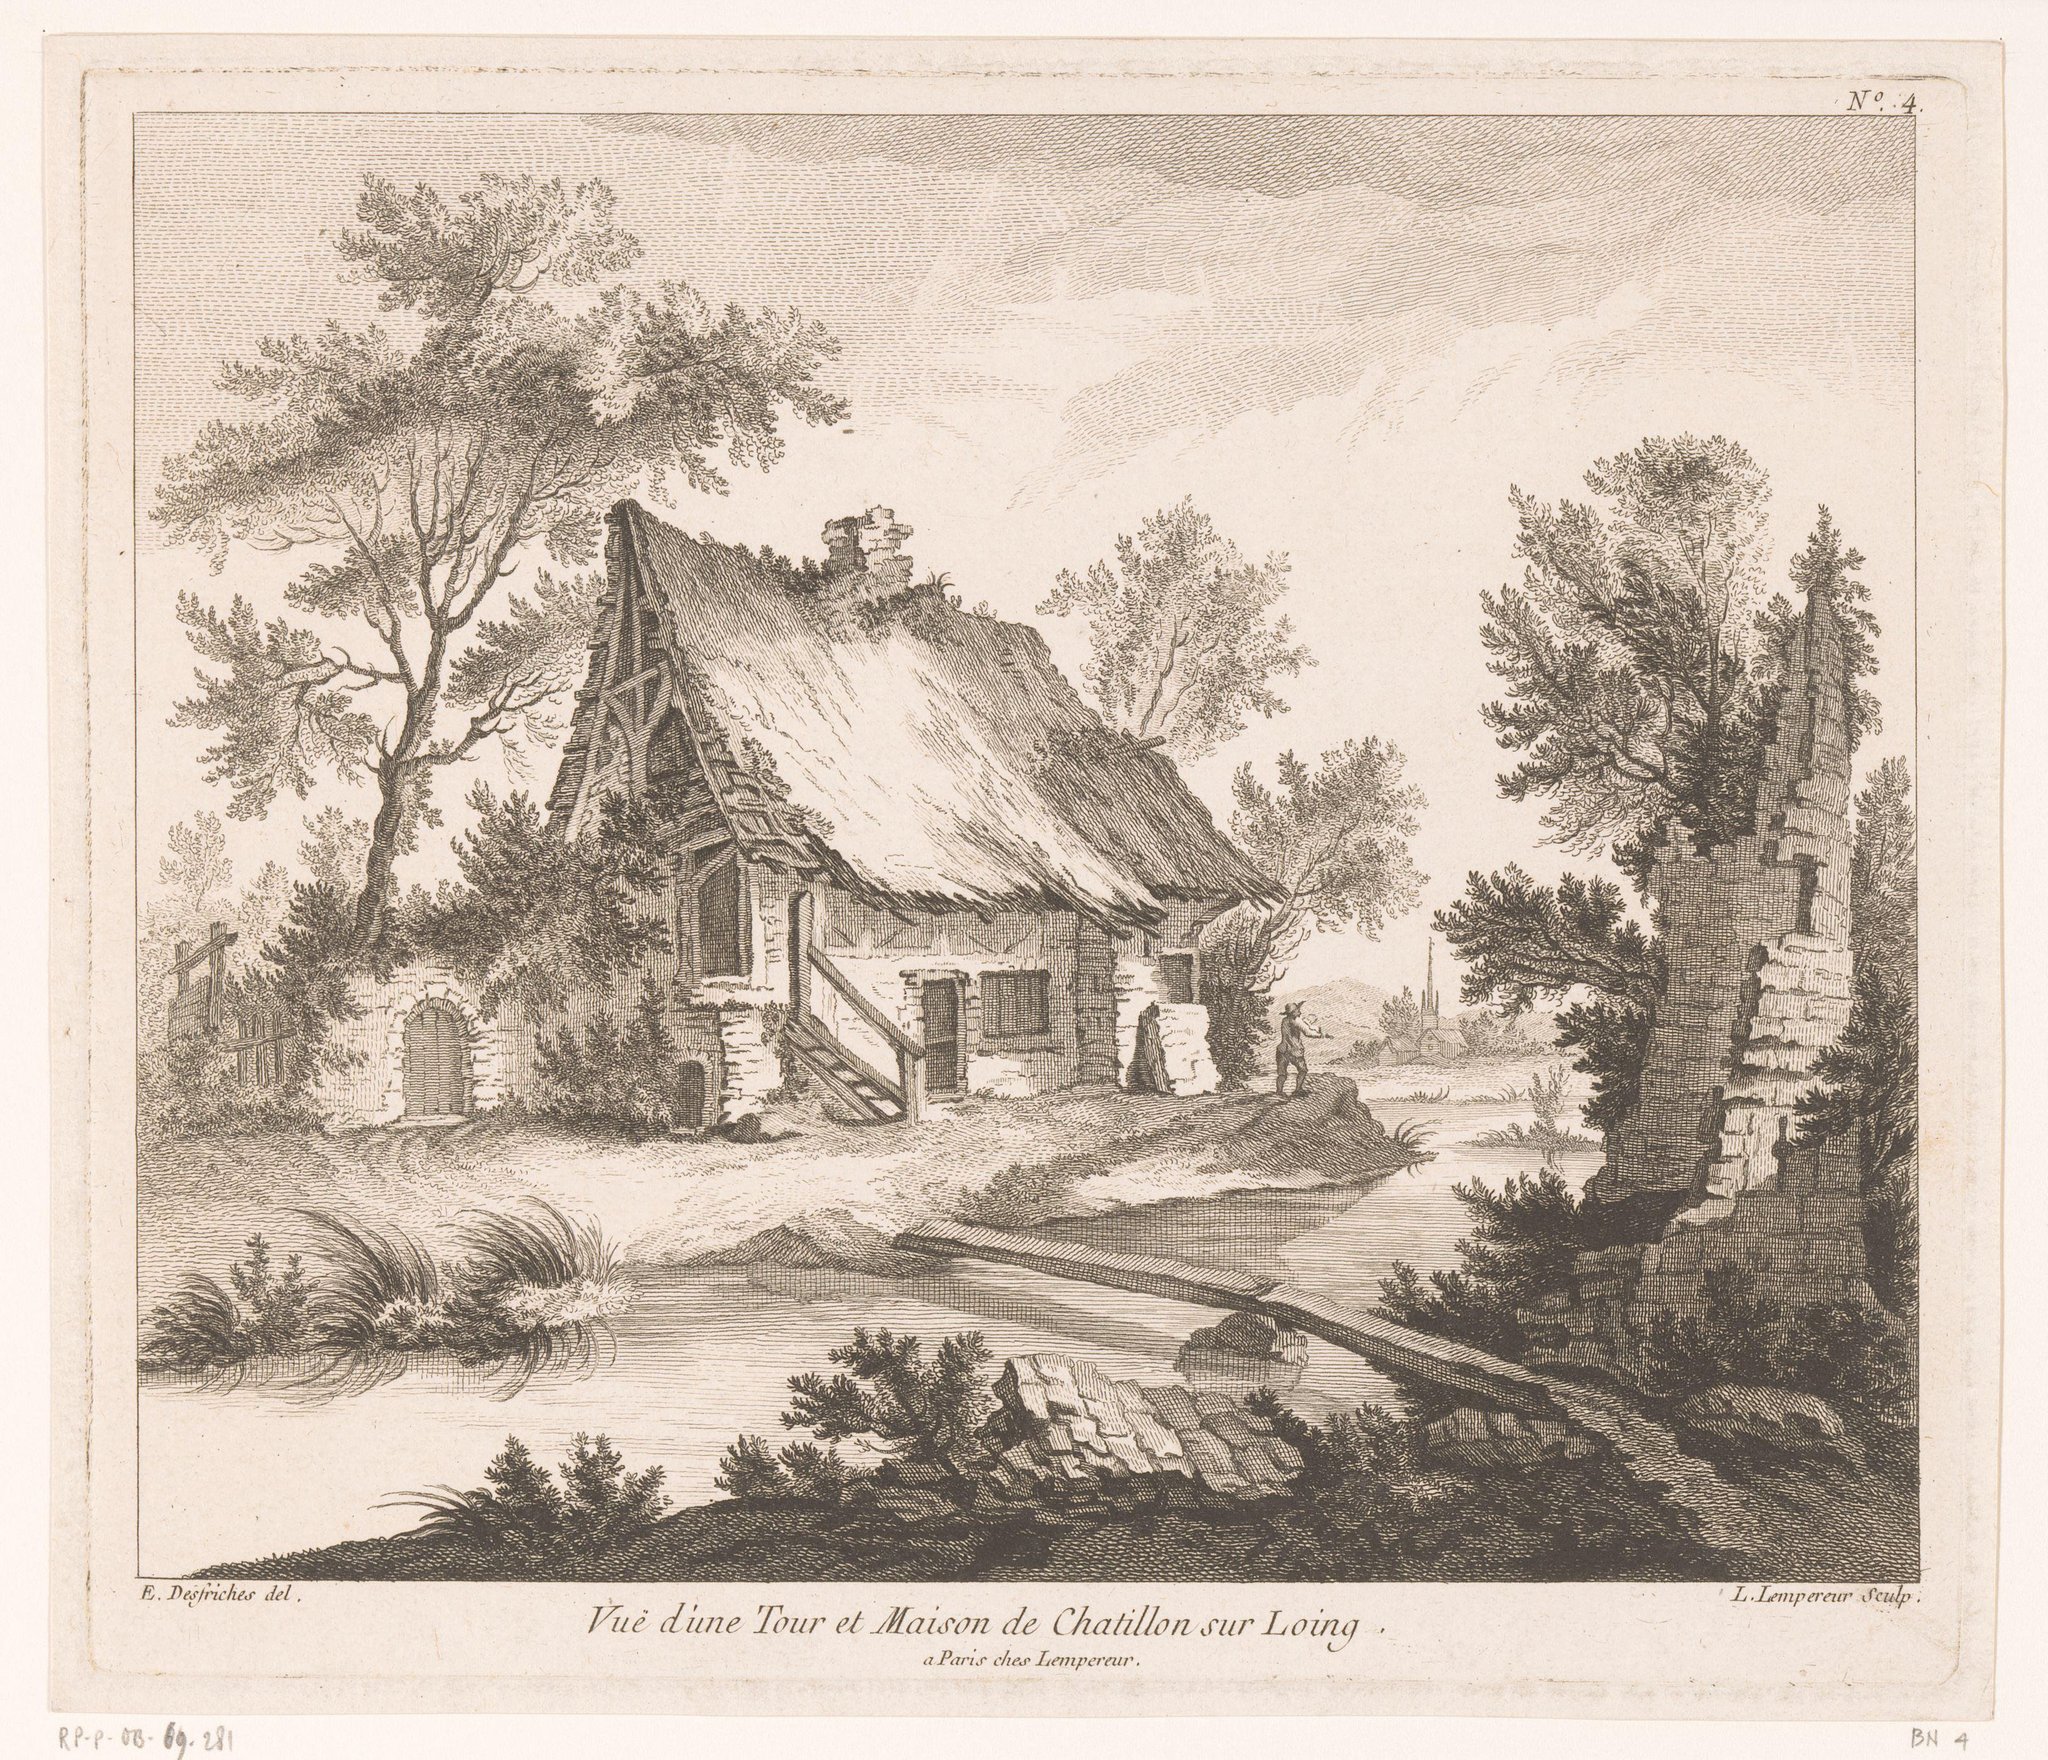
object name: print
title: Gezicht op een toren en een huis in Châtillon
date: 1738-1807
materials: paper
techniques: etching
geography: paris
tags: rural housing, e.g. country-house, villa, cottage, water course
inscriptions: collector's mark: Lugt 240